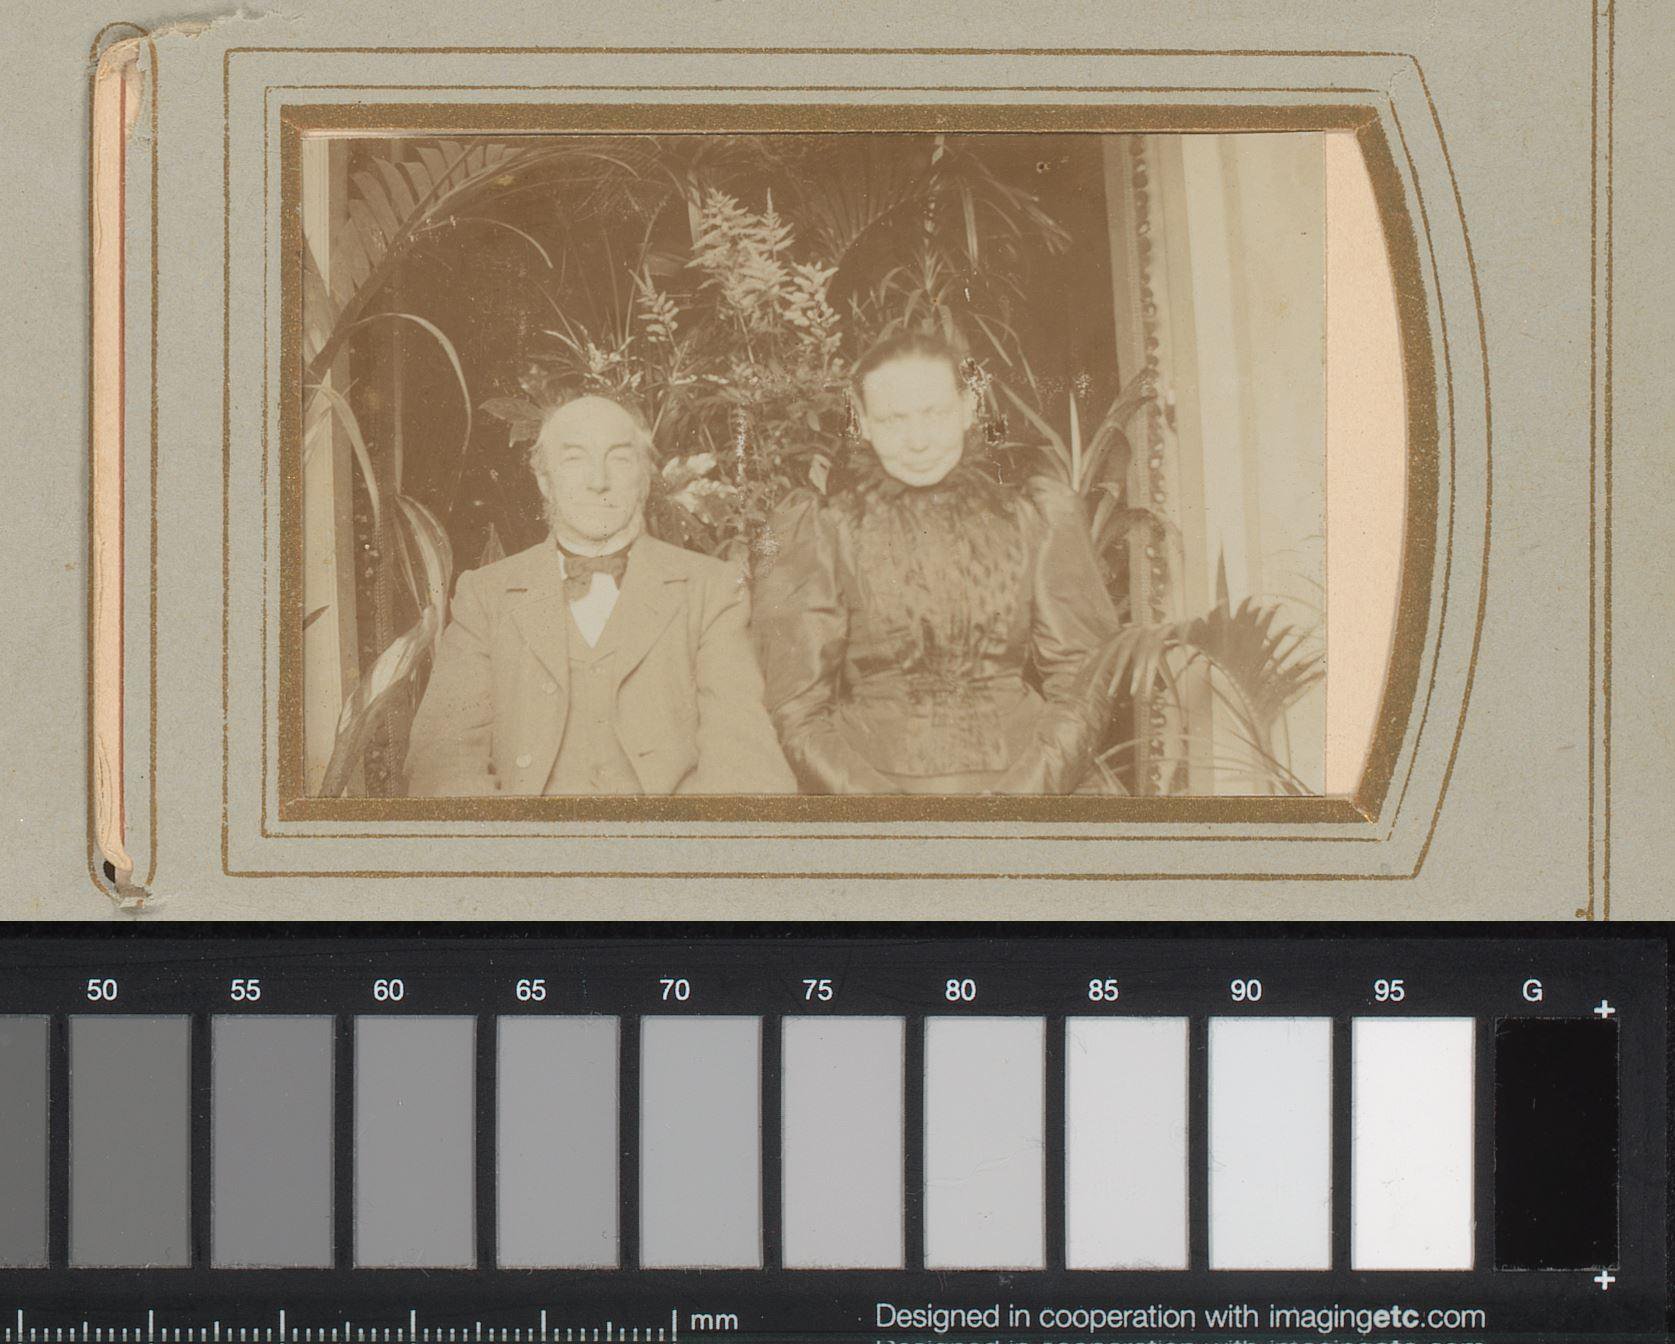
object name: album leaf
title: Portret van een man en een vrouw, zittend in vermoedelijk een serre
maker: Anonymous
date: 1880-1920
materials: cardboard, photographic support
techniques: collodion silver print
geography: netherlands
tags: historical persons - bb - woman, historical persons, greenhouse, orangery